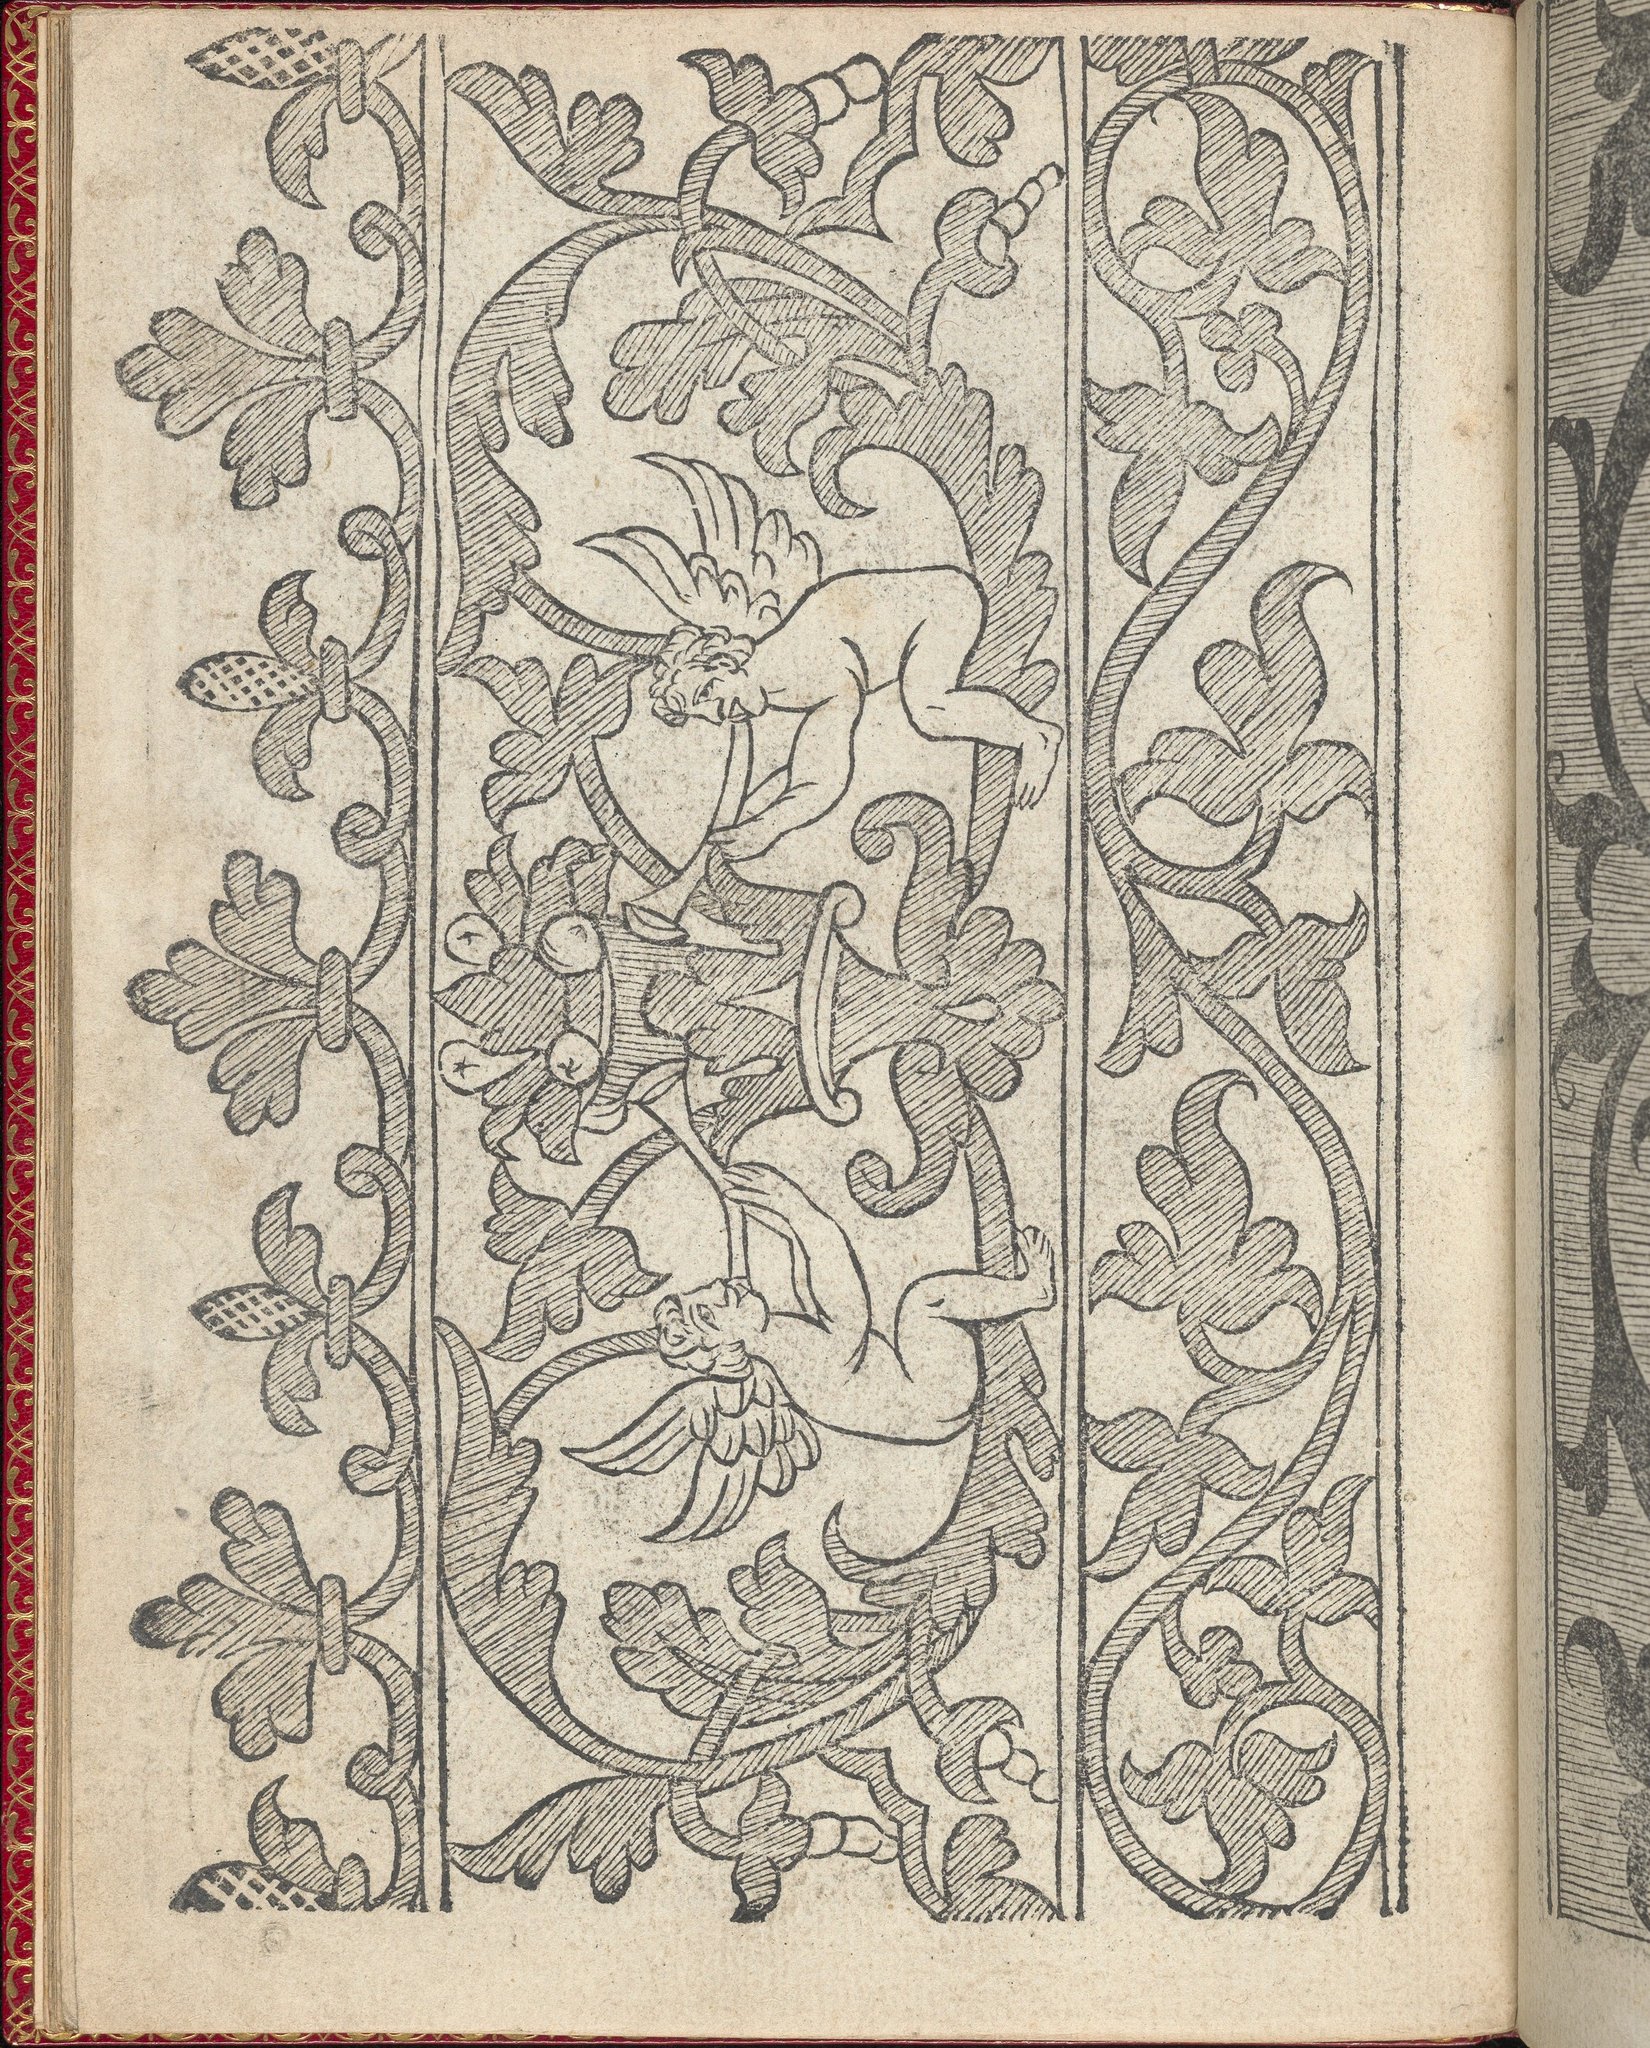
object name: book print ornament architecture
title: Il Monte. Opera Nova di Recami, page 8 (verso)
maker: giovanni antonio bindoni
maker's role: designer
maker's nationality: italian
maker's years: 1500-1650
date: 1557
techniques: woodcut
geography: italy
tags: ornament,horns,putti,vines